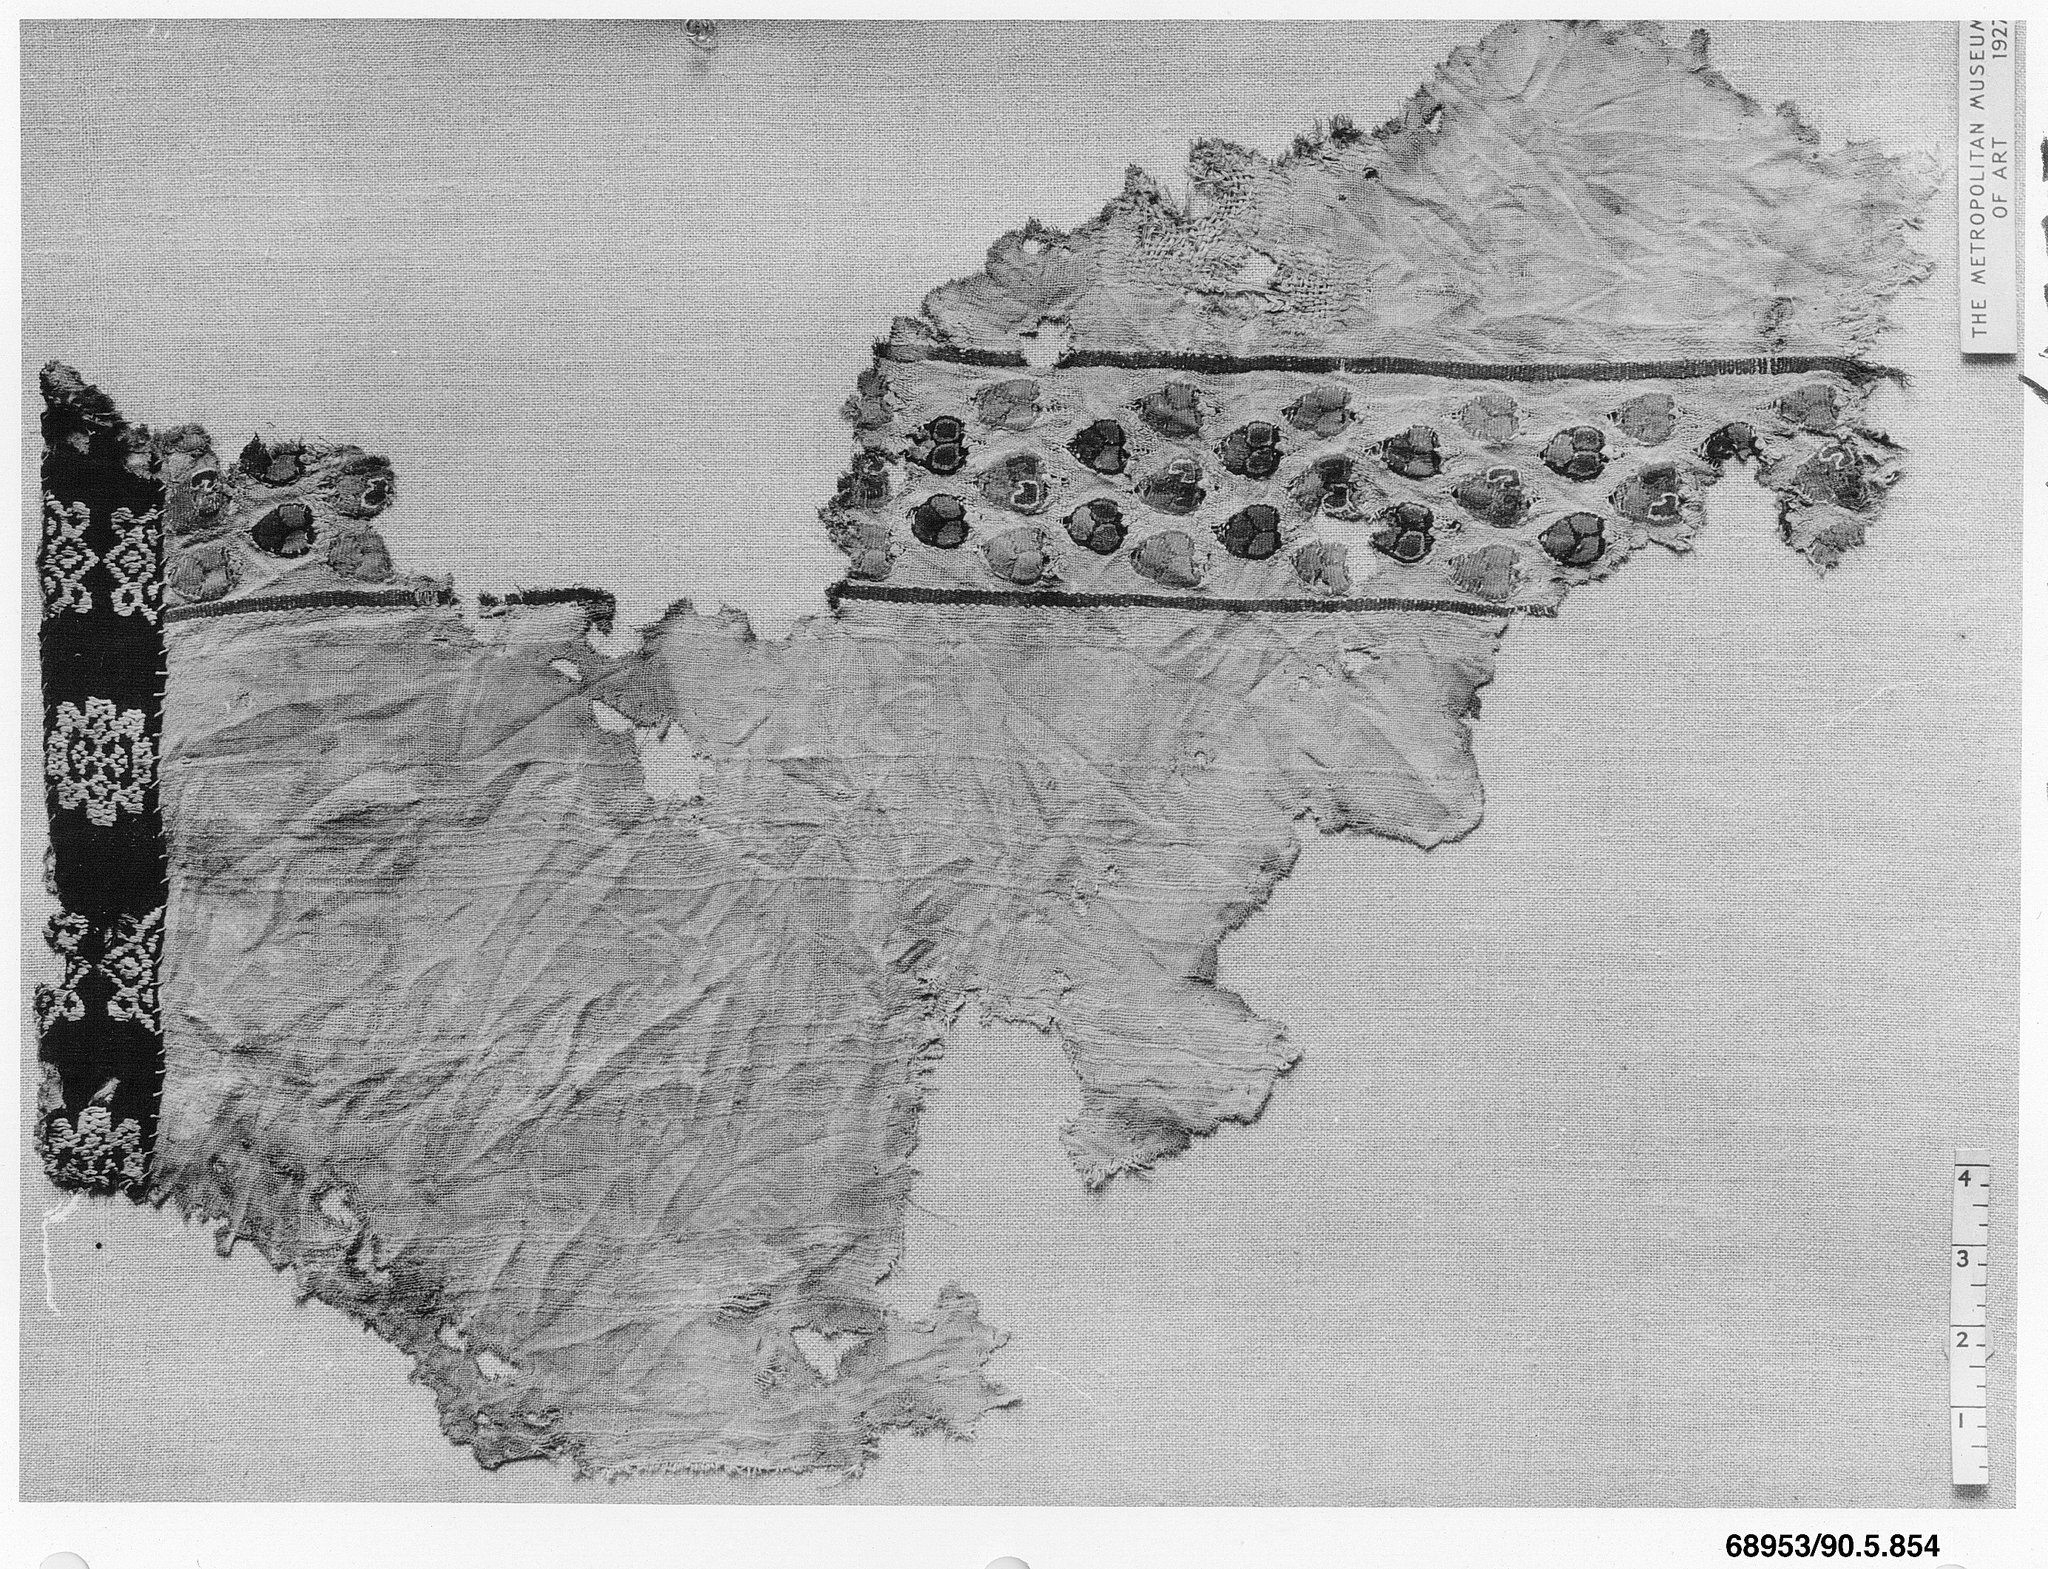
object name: tunic fragment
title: Fragment of a Tunic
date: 401-600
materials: linen, wool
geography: egypt